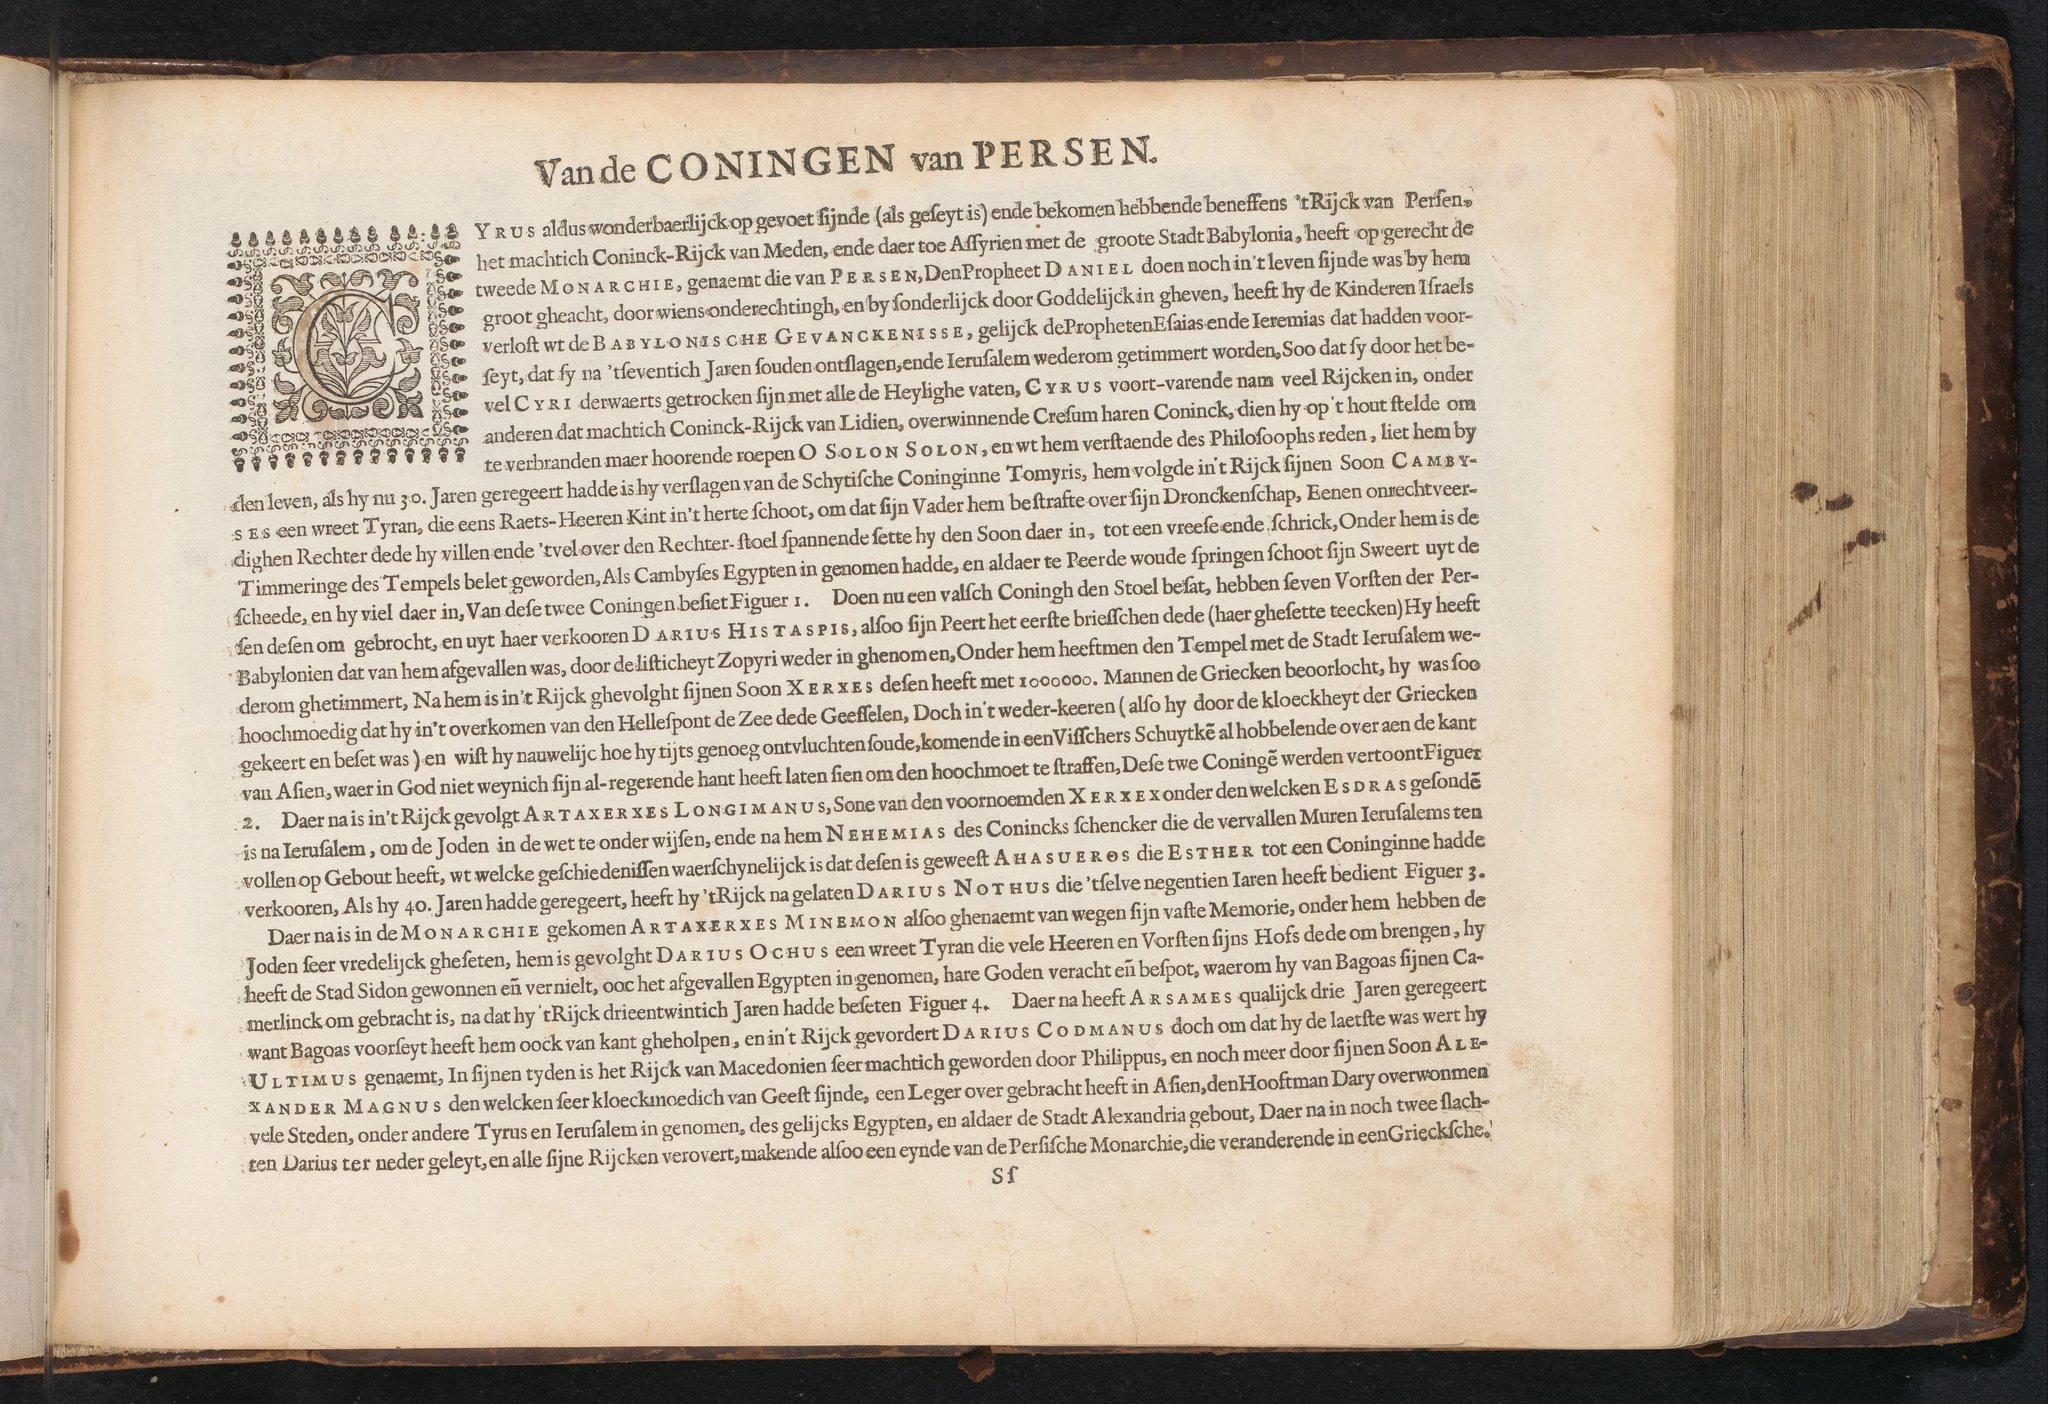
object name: text sheet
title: Den Grooten Figuer-Bibel (...)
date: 1646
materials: paper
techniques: hand coloring, letterpress printing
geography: alkmaar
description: Tekstblad bij een serie prenten over de Perzische koningen. Linksboven initiaal C. Dit blad maakt deel uit van een album.